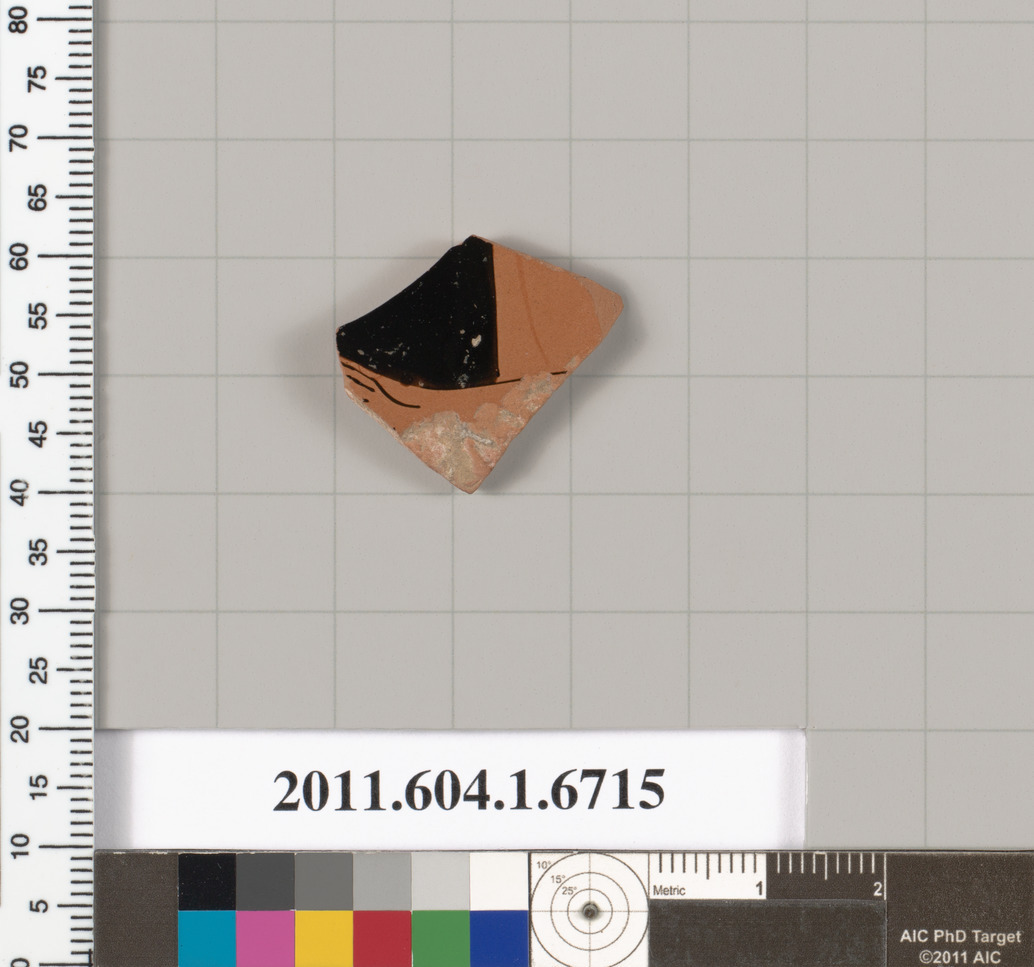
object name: kylix fragment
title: Terracotta fragment of a kylix (drinking cup)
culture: greek, attic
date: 490-470 BCE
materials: terracotta